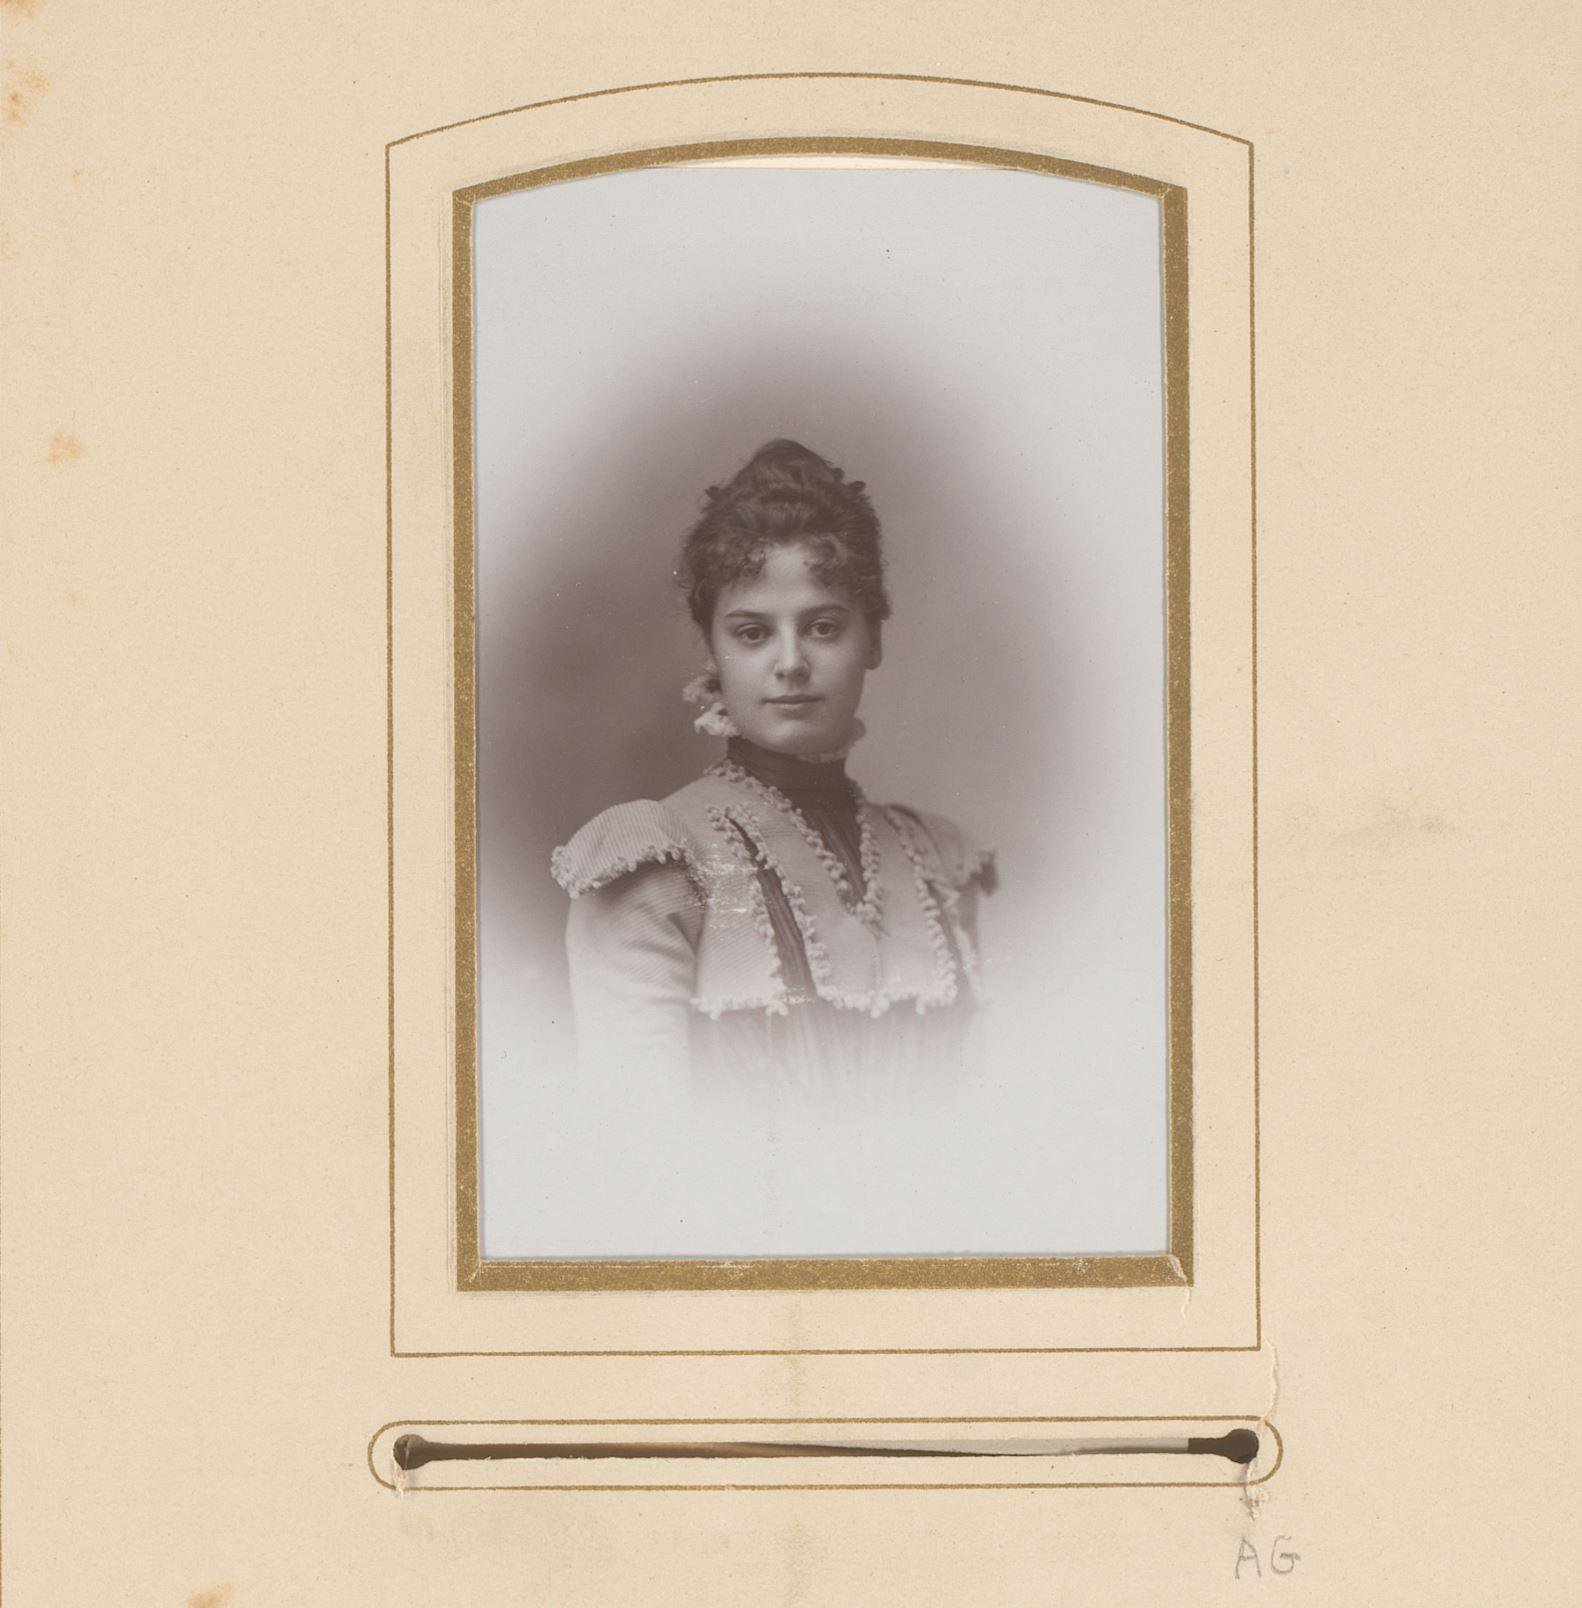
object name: album leaf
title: Portret van een jonge vrouw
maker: christian beitz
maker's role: fotograaf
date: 1880-1920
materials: cardboard, photographic support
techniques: collodion silver print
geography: arnstadt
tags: adolescent, young woman, maiden, historical persons - bb - woman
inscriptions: inscription: ‘Chr. Beitz/ Ho[f-Photo]graph’